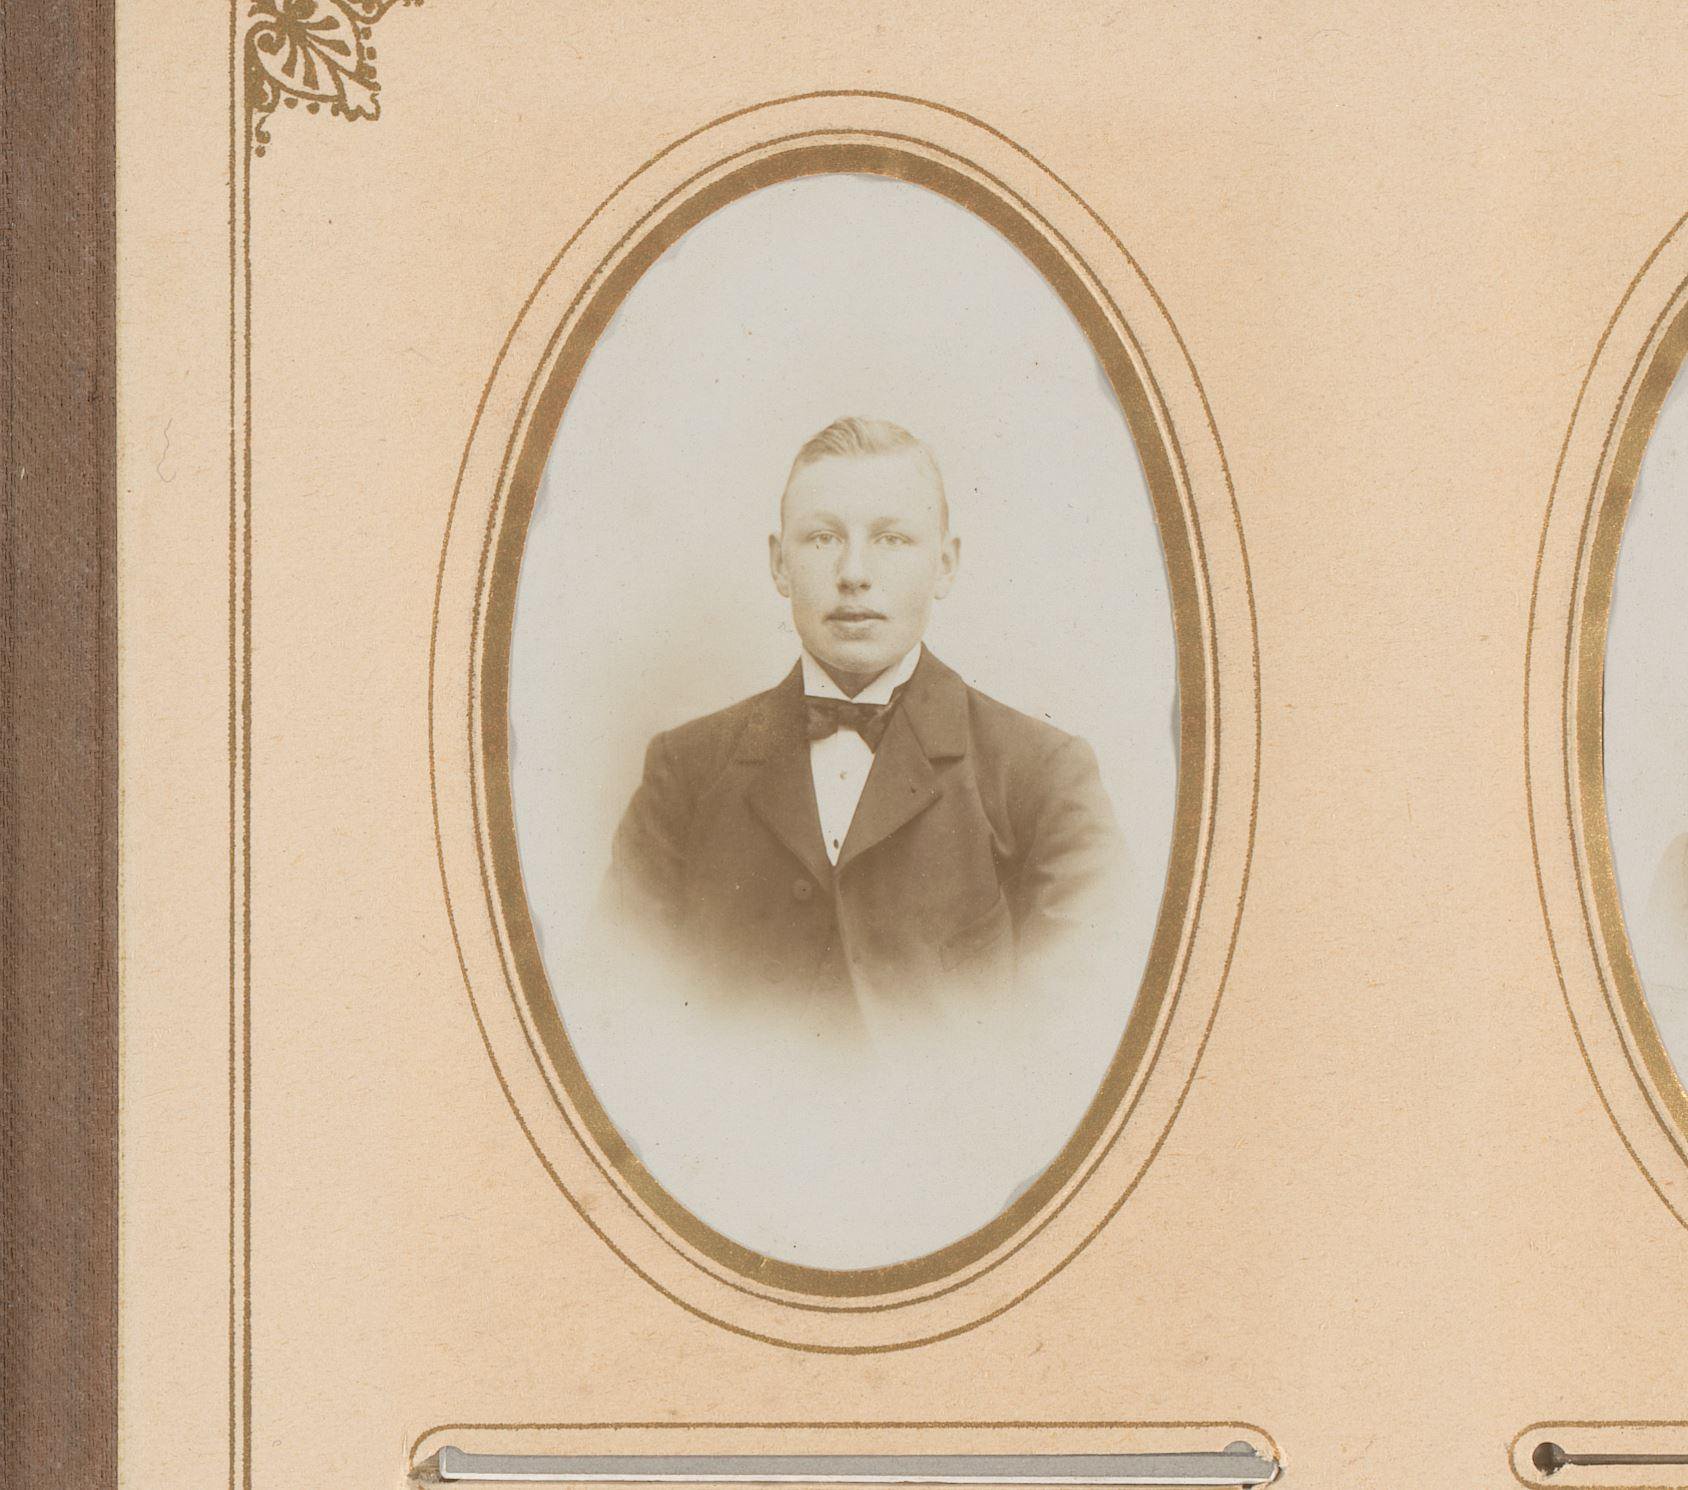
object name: album leaf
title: Portret van een jonge man met vlinderstrik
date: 1890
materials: cardboard, photographic support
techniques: collodion silver print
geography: edam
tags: historical persons, youth, adolescent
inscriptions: inscription: ‘Photographische/ Ateliers/ J. Siewers & Zoon/ Edam/ Hilversum./ Specialiteit in vergrootingen.’